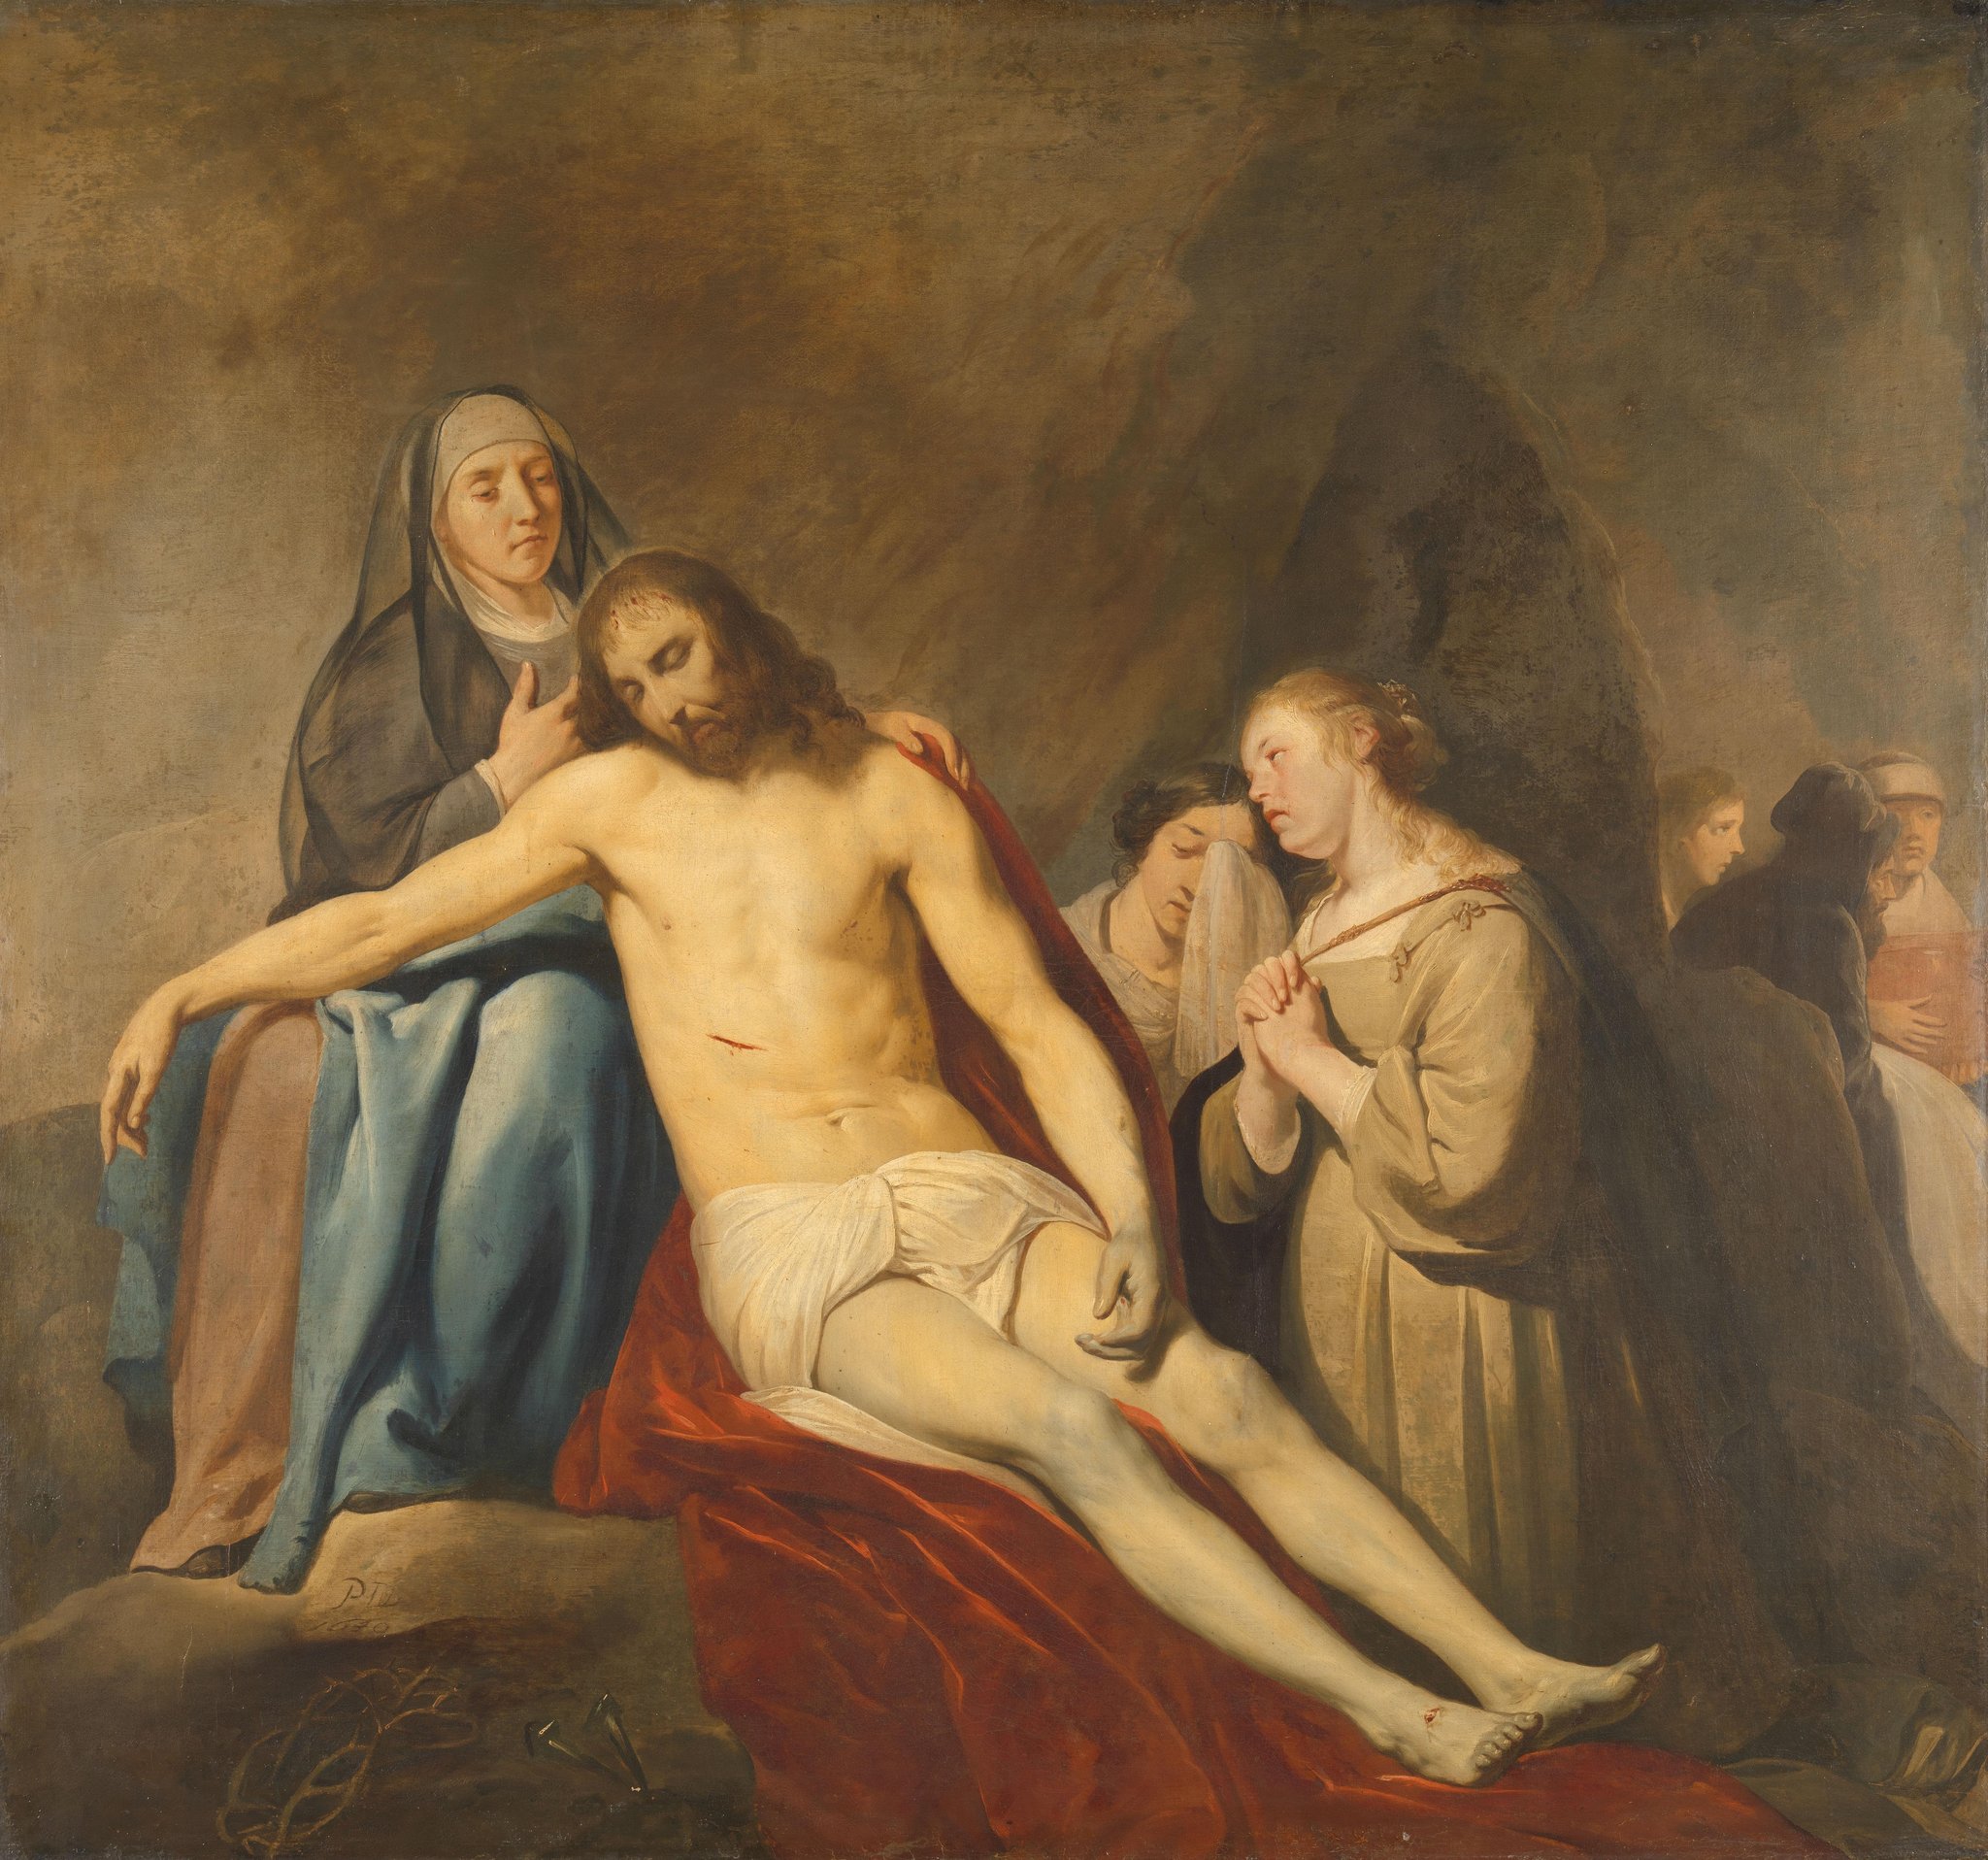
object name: painting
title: The Lamentation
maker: pieter fransz de grebber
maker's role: painter, print maker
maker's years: 1600-1653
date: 1640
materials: canvas, oil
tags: christ's body supported by mary, others present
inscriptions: signature and date: ‘P. DG 1640’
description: De bewening van Christus door de heilige vrouwen.